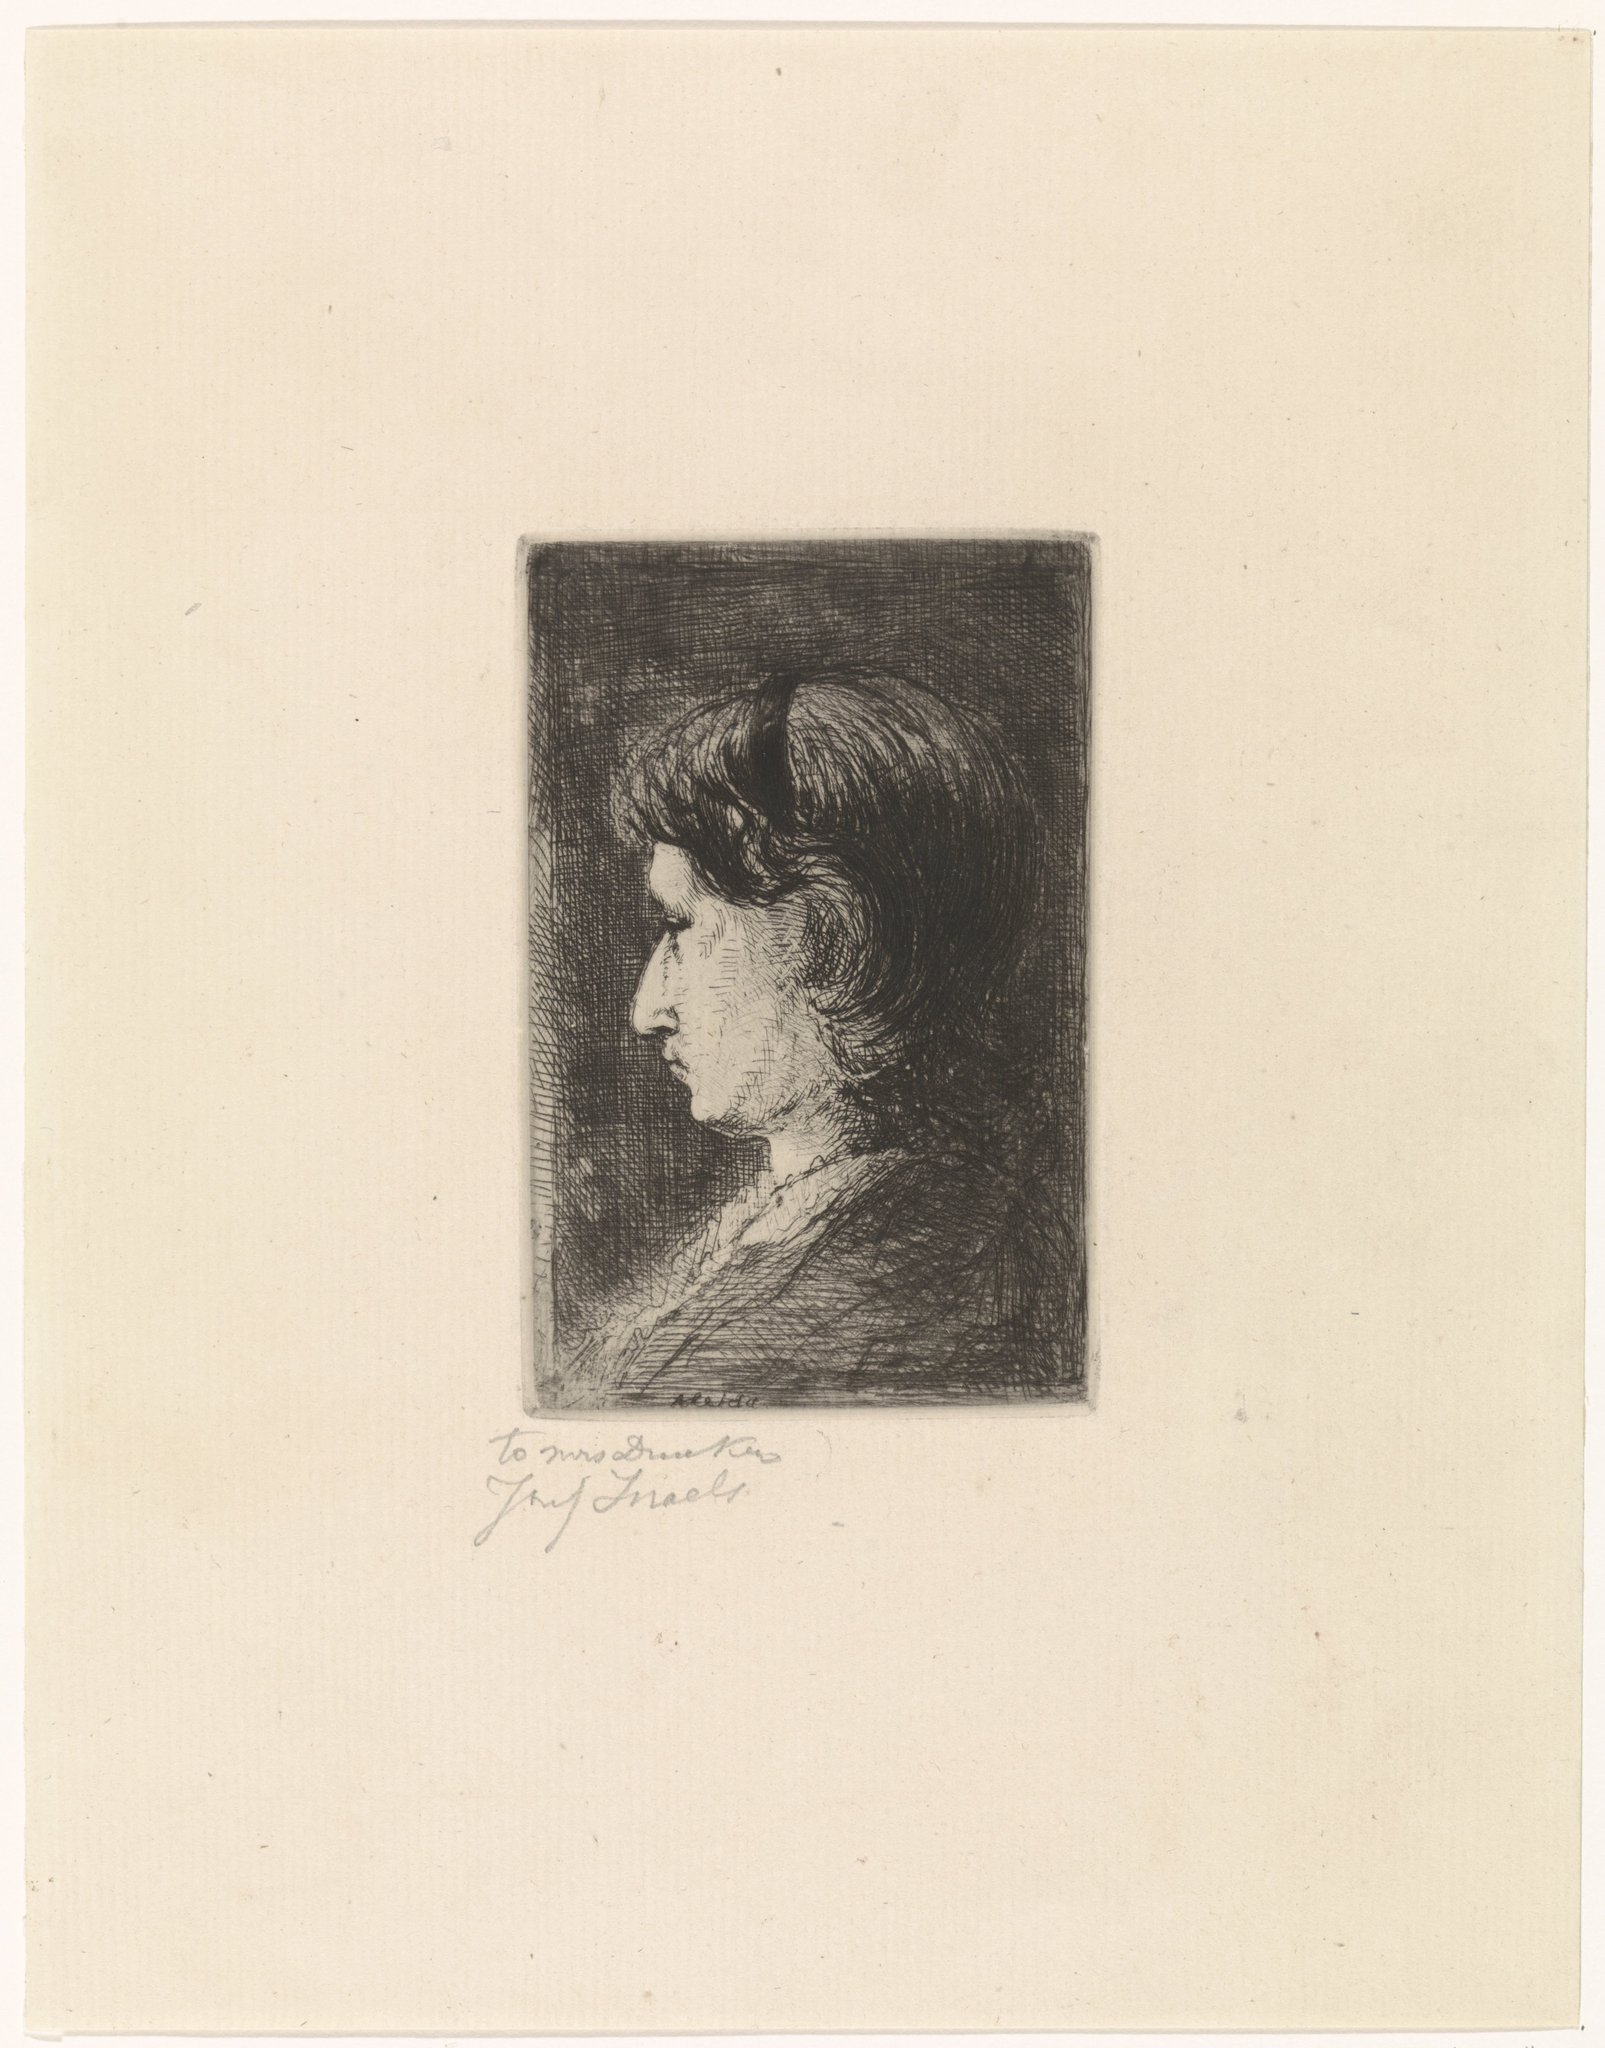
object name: print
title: Portret van Aleida Schaap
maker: jozef israëls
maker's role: draughtsman, painter, print maker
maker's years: 1824-1911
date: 1863-1878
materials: paper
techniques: etching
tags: aleida schaap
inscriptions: signature: ‘To mrs [...] Jozef Israels’, collector's mark: Lugt 2228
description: Portret van Aleida Schaap, vrouw van kunstenaar Jozef Israëls, met haarband. Links onder de voorstelling: "Aleida".